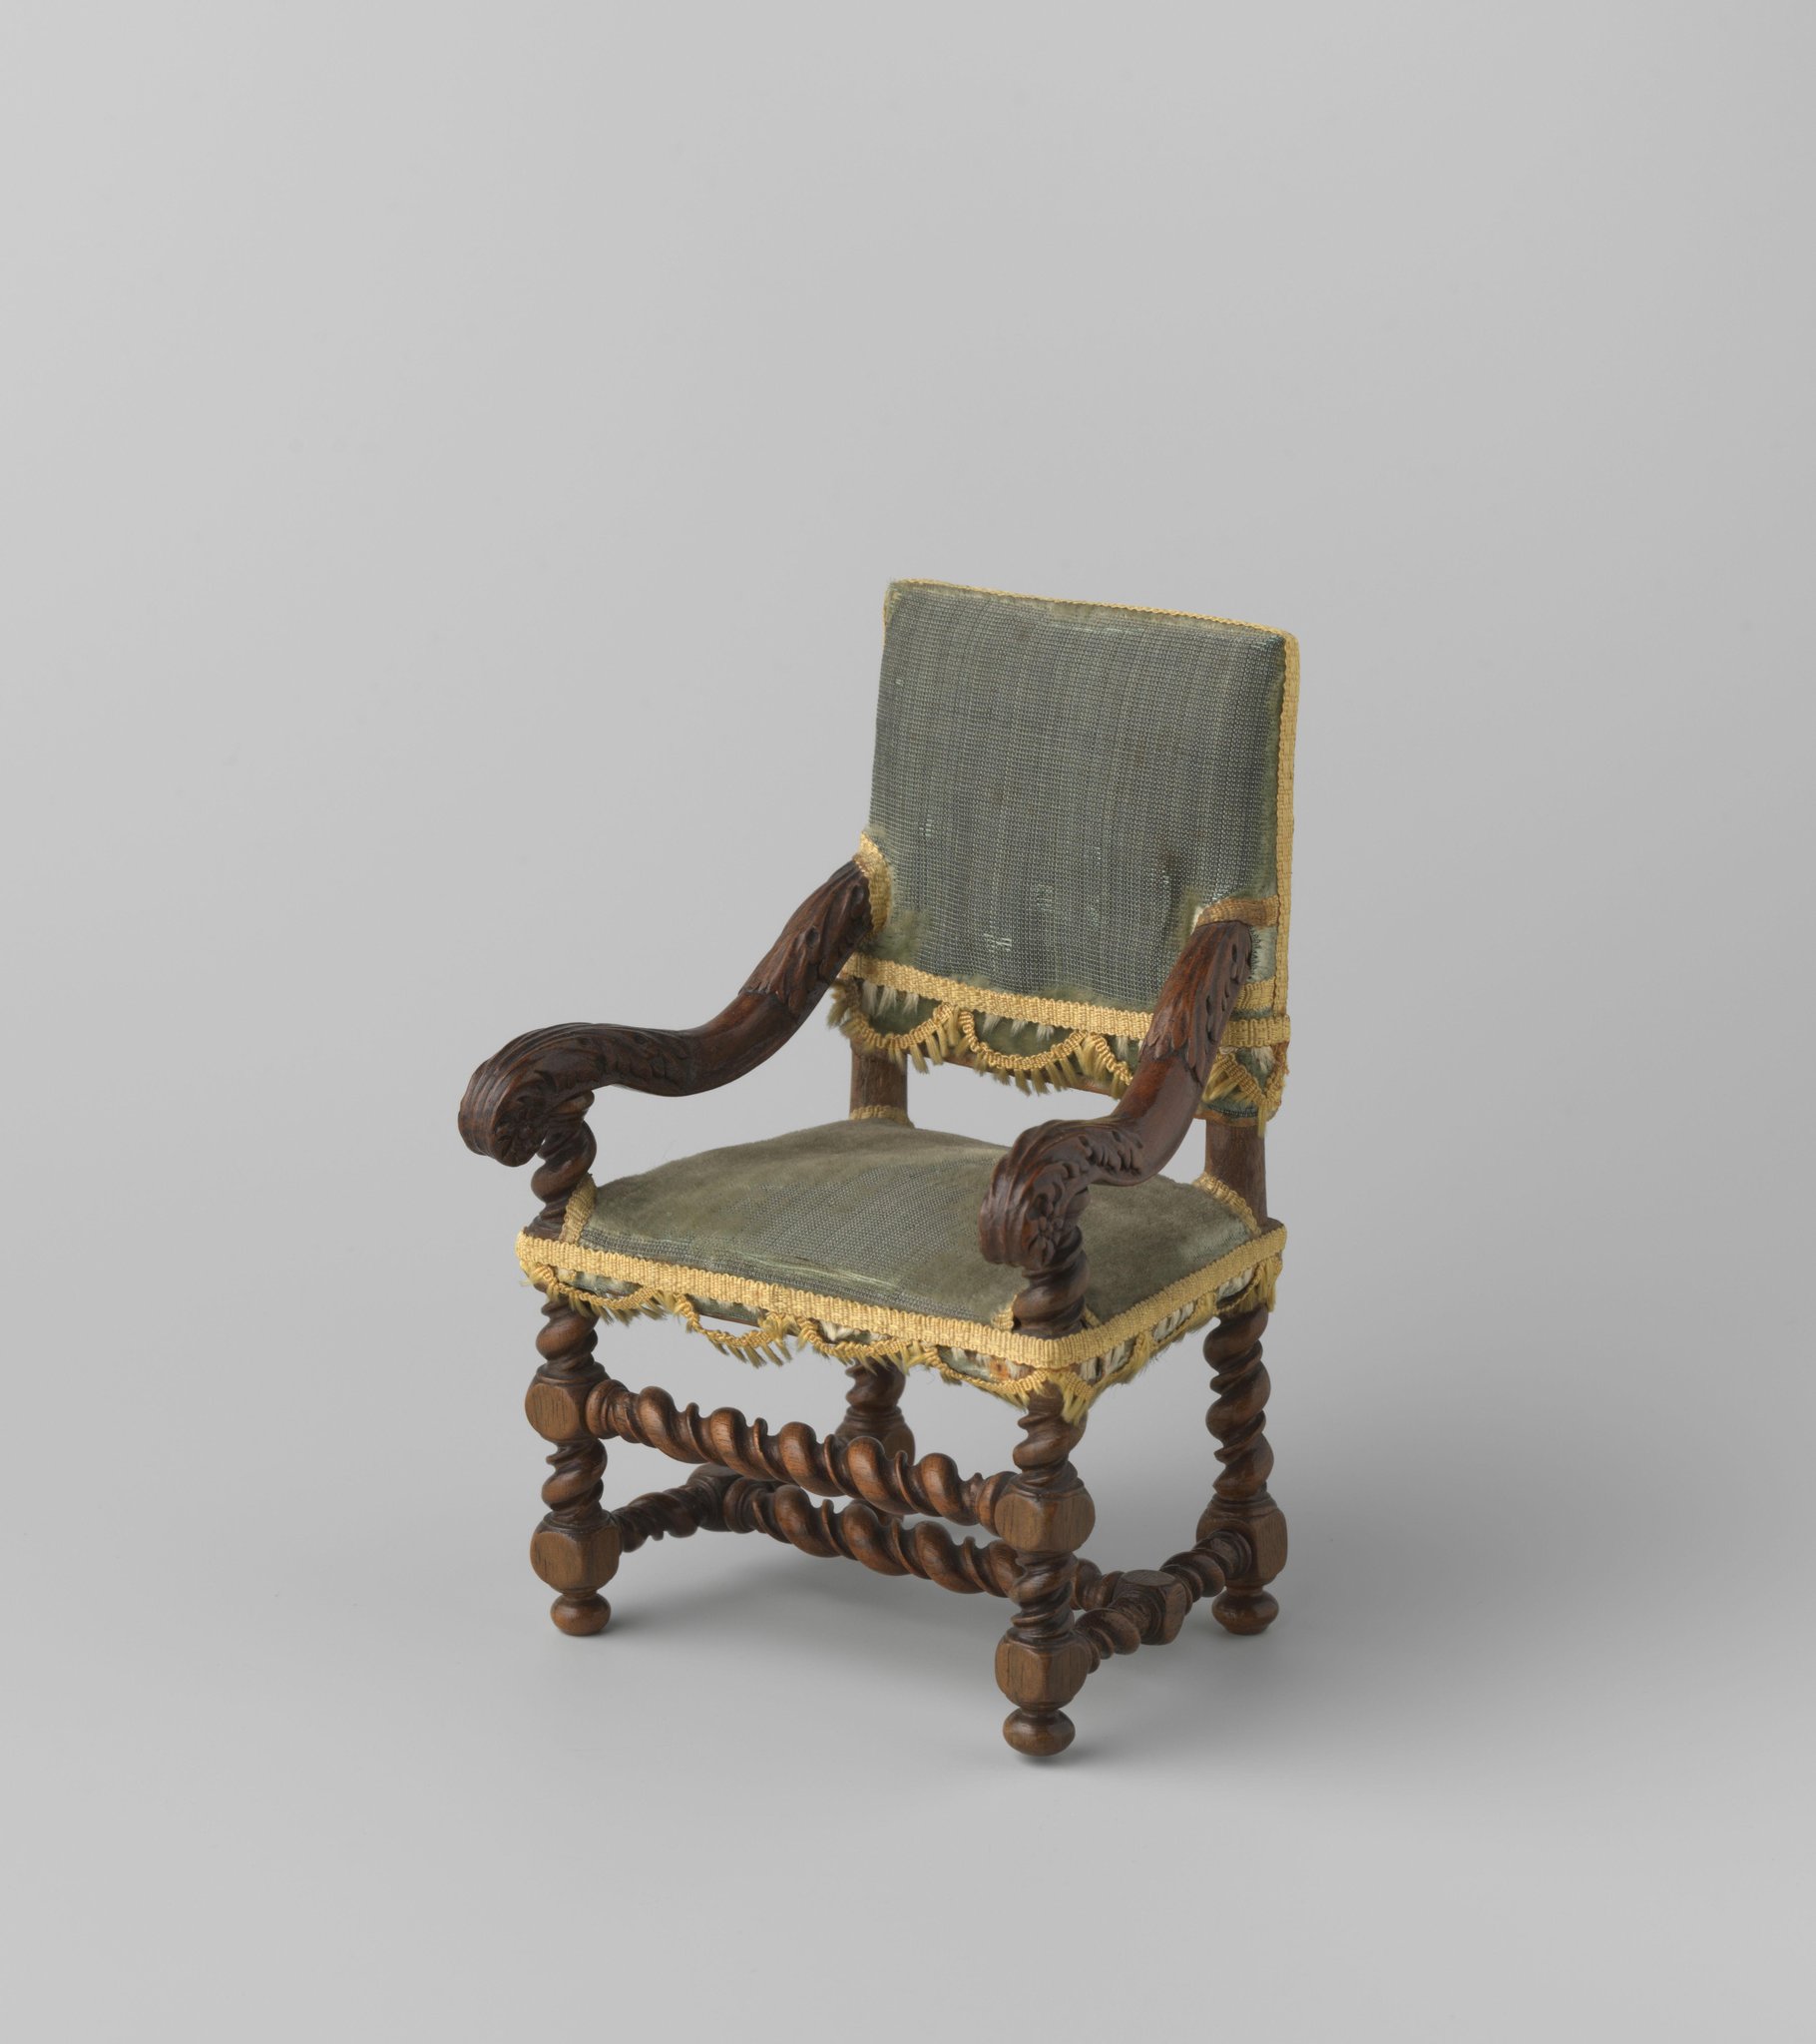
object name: armchair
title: Armstoel met bekleding van zijdefluweel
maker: Anonymous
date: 1690-1710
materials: linen, board, silk, wood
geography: amsterdam